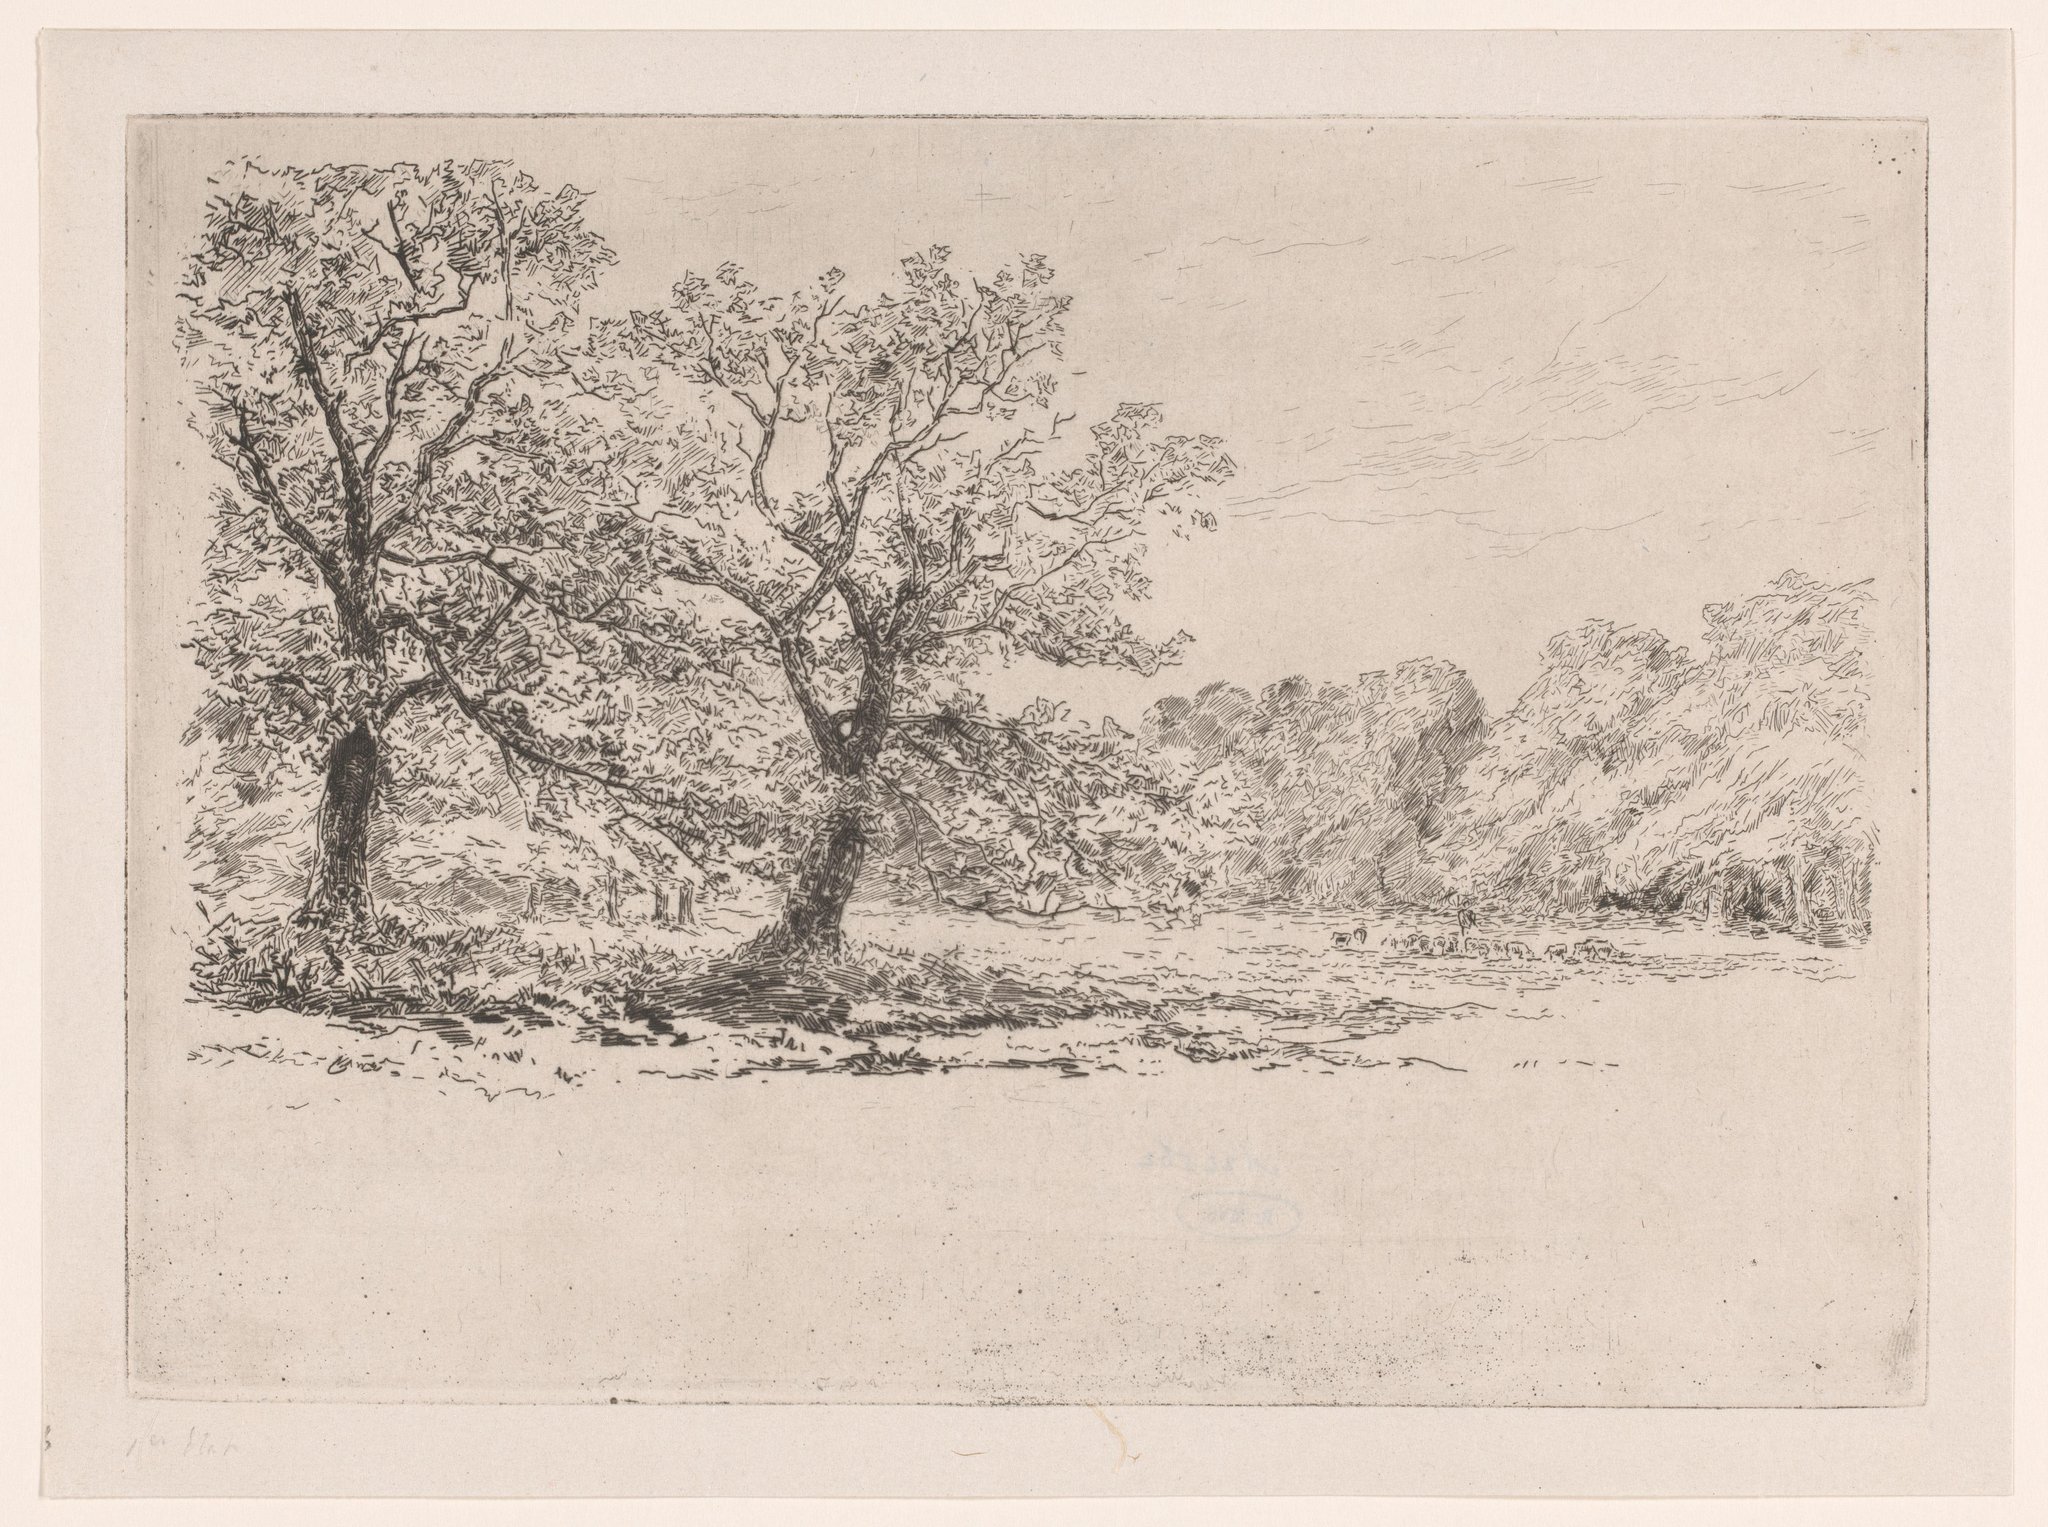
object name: print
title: Landschap met schaapskudde bij Bloemendaal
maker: carel nicolaas storm van s-gravesande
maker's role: draughtsman, print maker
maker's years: 1841-1924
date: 1880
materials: paper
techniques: etching, intaglio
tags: meadow, pasture, herd, flock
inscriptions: collector's mark: Lugt 2228